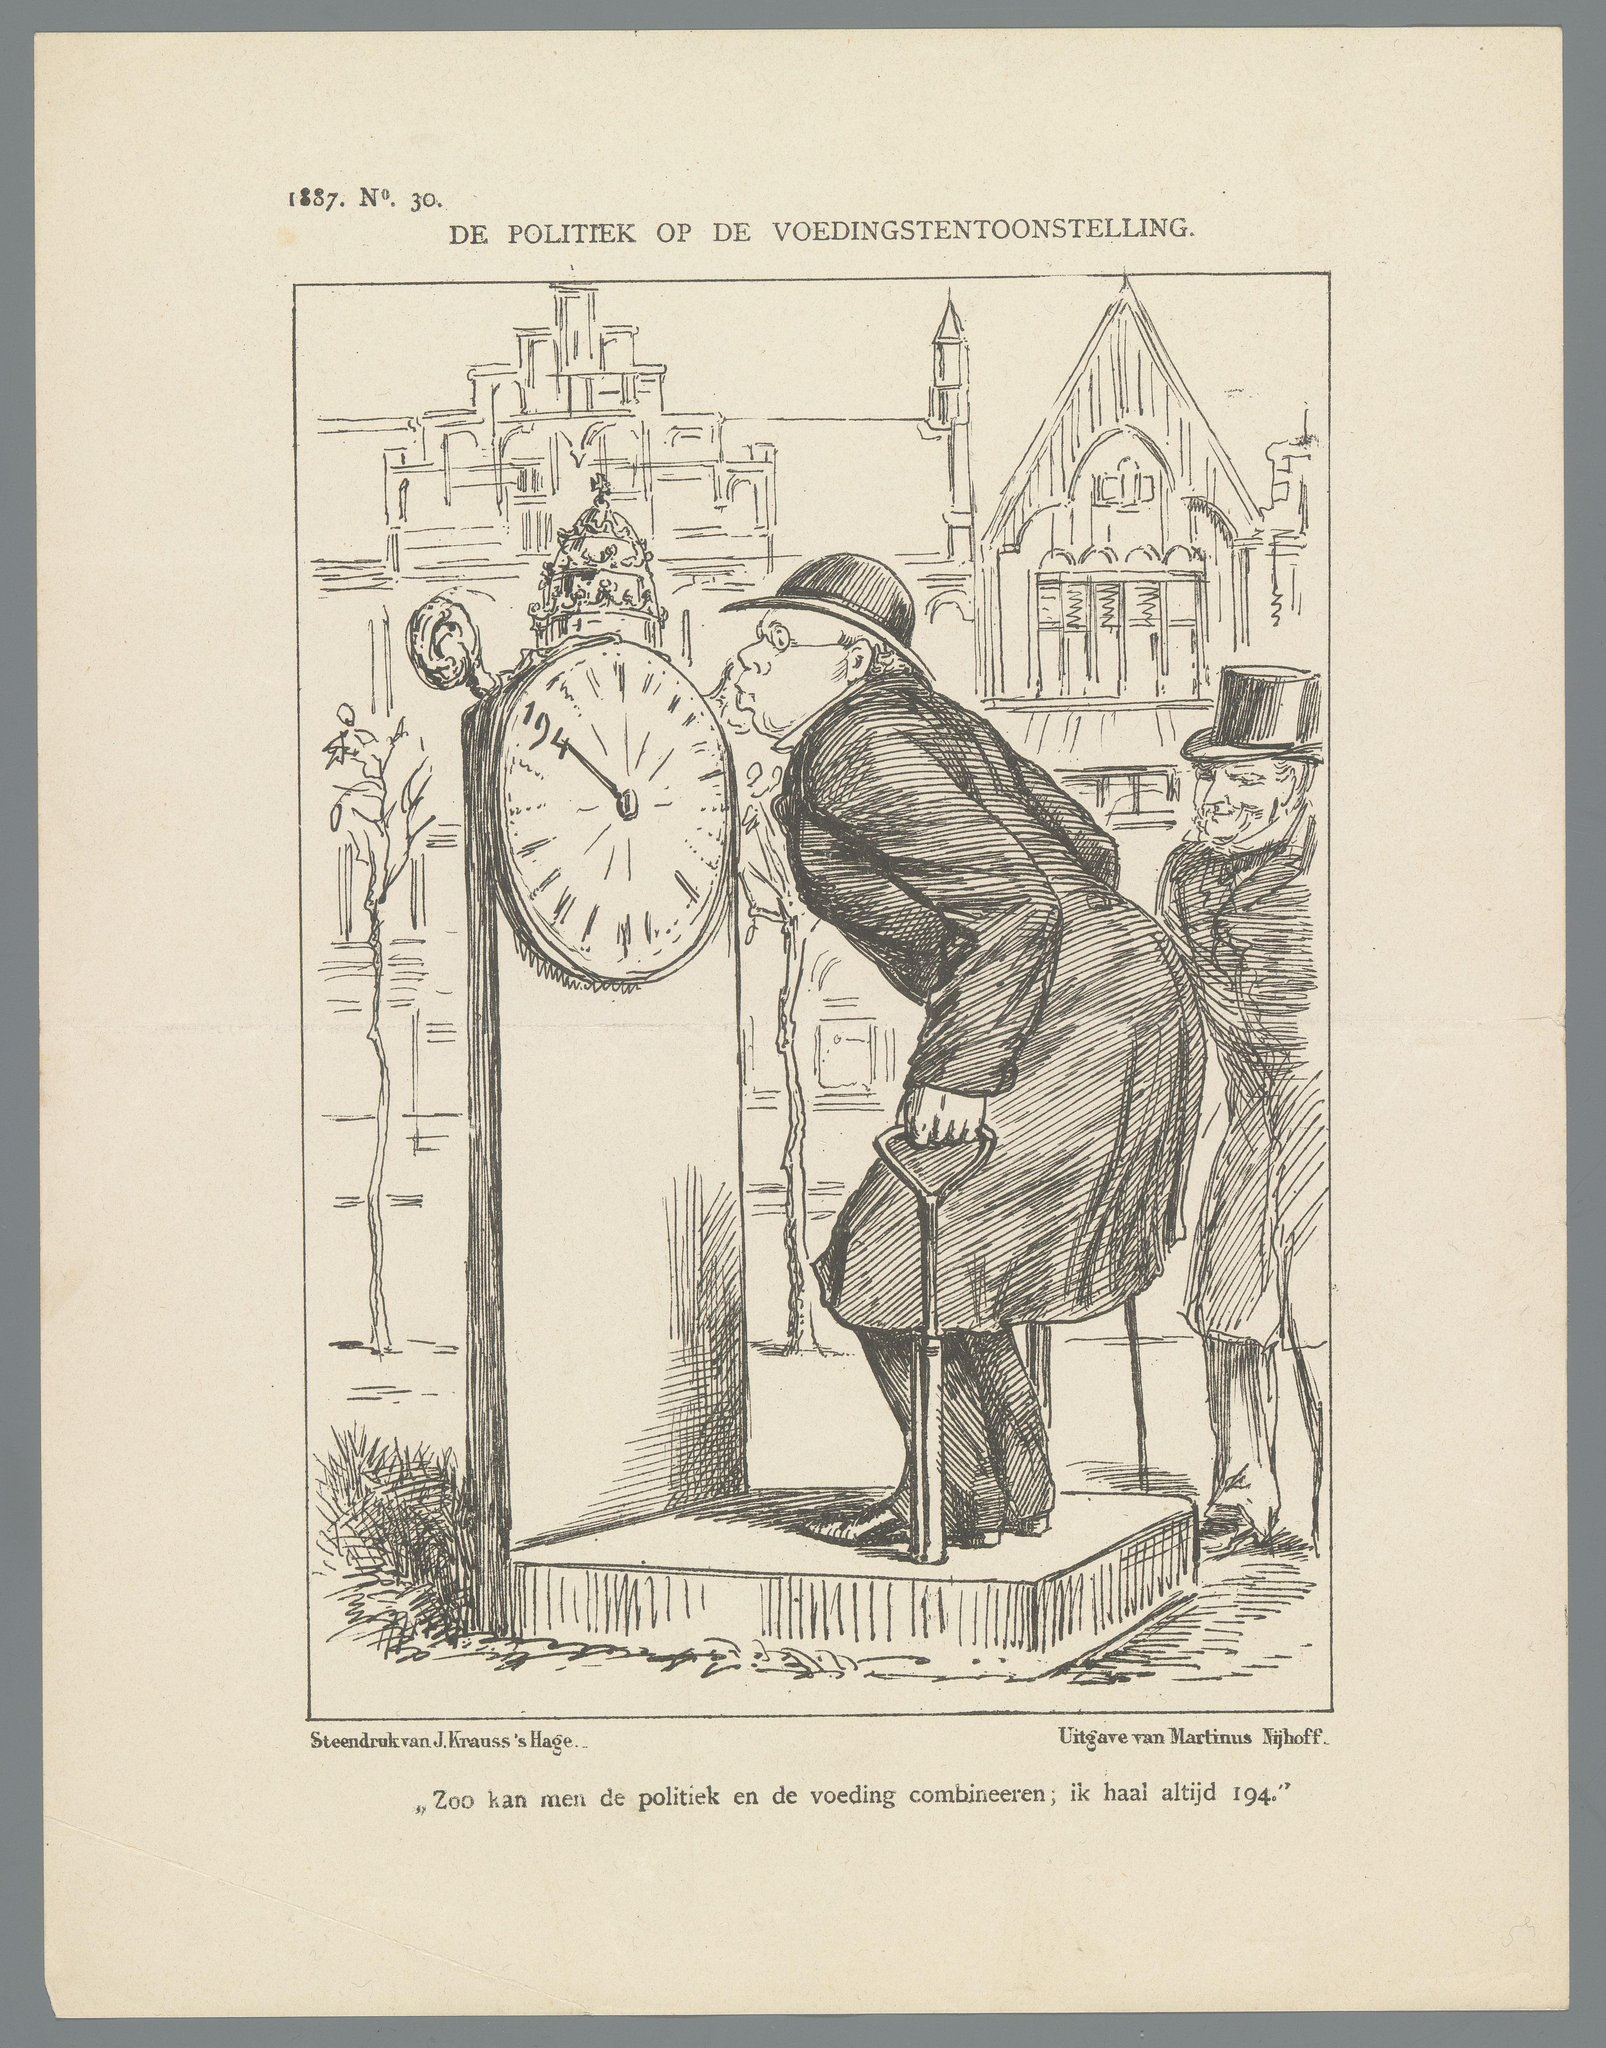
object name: print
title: De politiek op de voedingstentoonstelling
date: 1887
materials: paper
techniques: lithograph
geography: netherlands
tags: priest, herman johannes aloysius maria schaepman, amsterdam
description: Spotprent met Schaepman op de weegschaal op de Voedingstentoonstelling te Amsterdam, 1887. Plaat verschenen bij het weekblad De Nederlandsche Spectator, nr. 30, 1887.